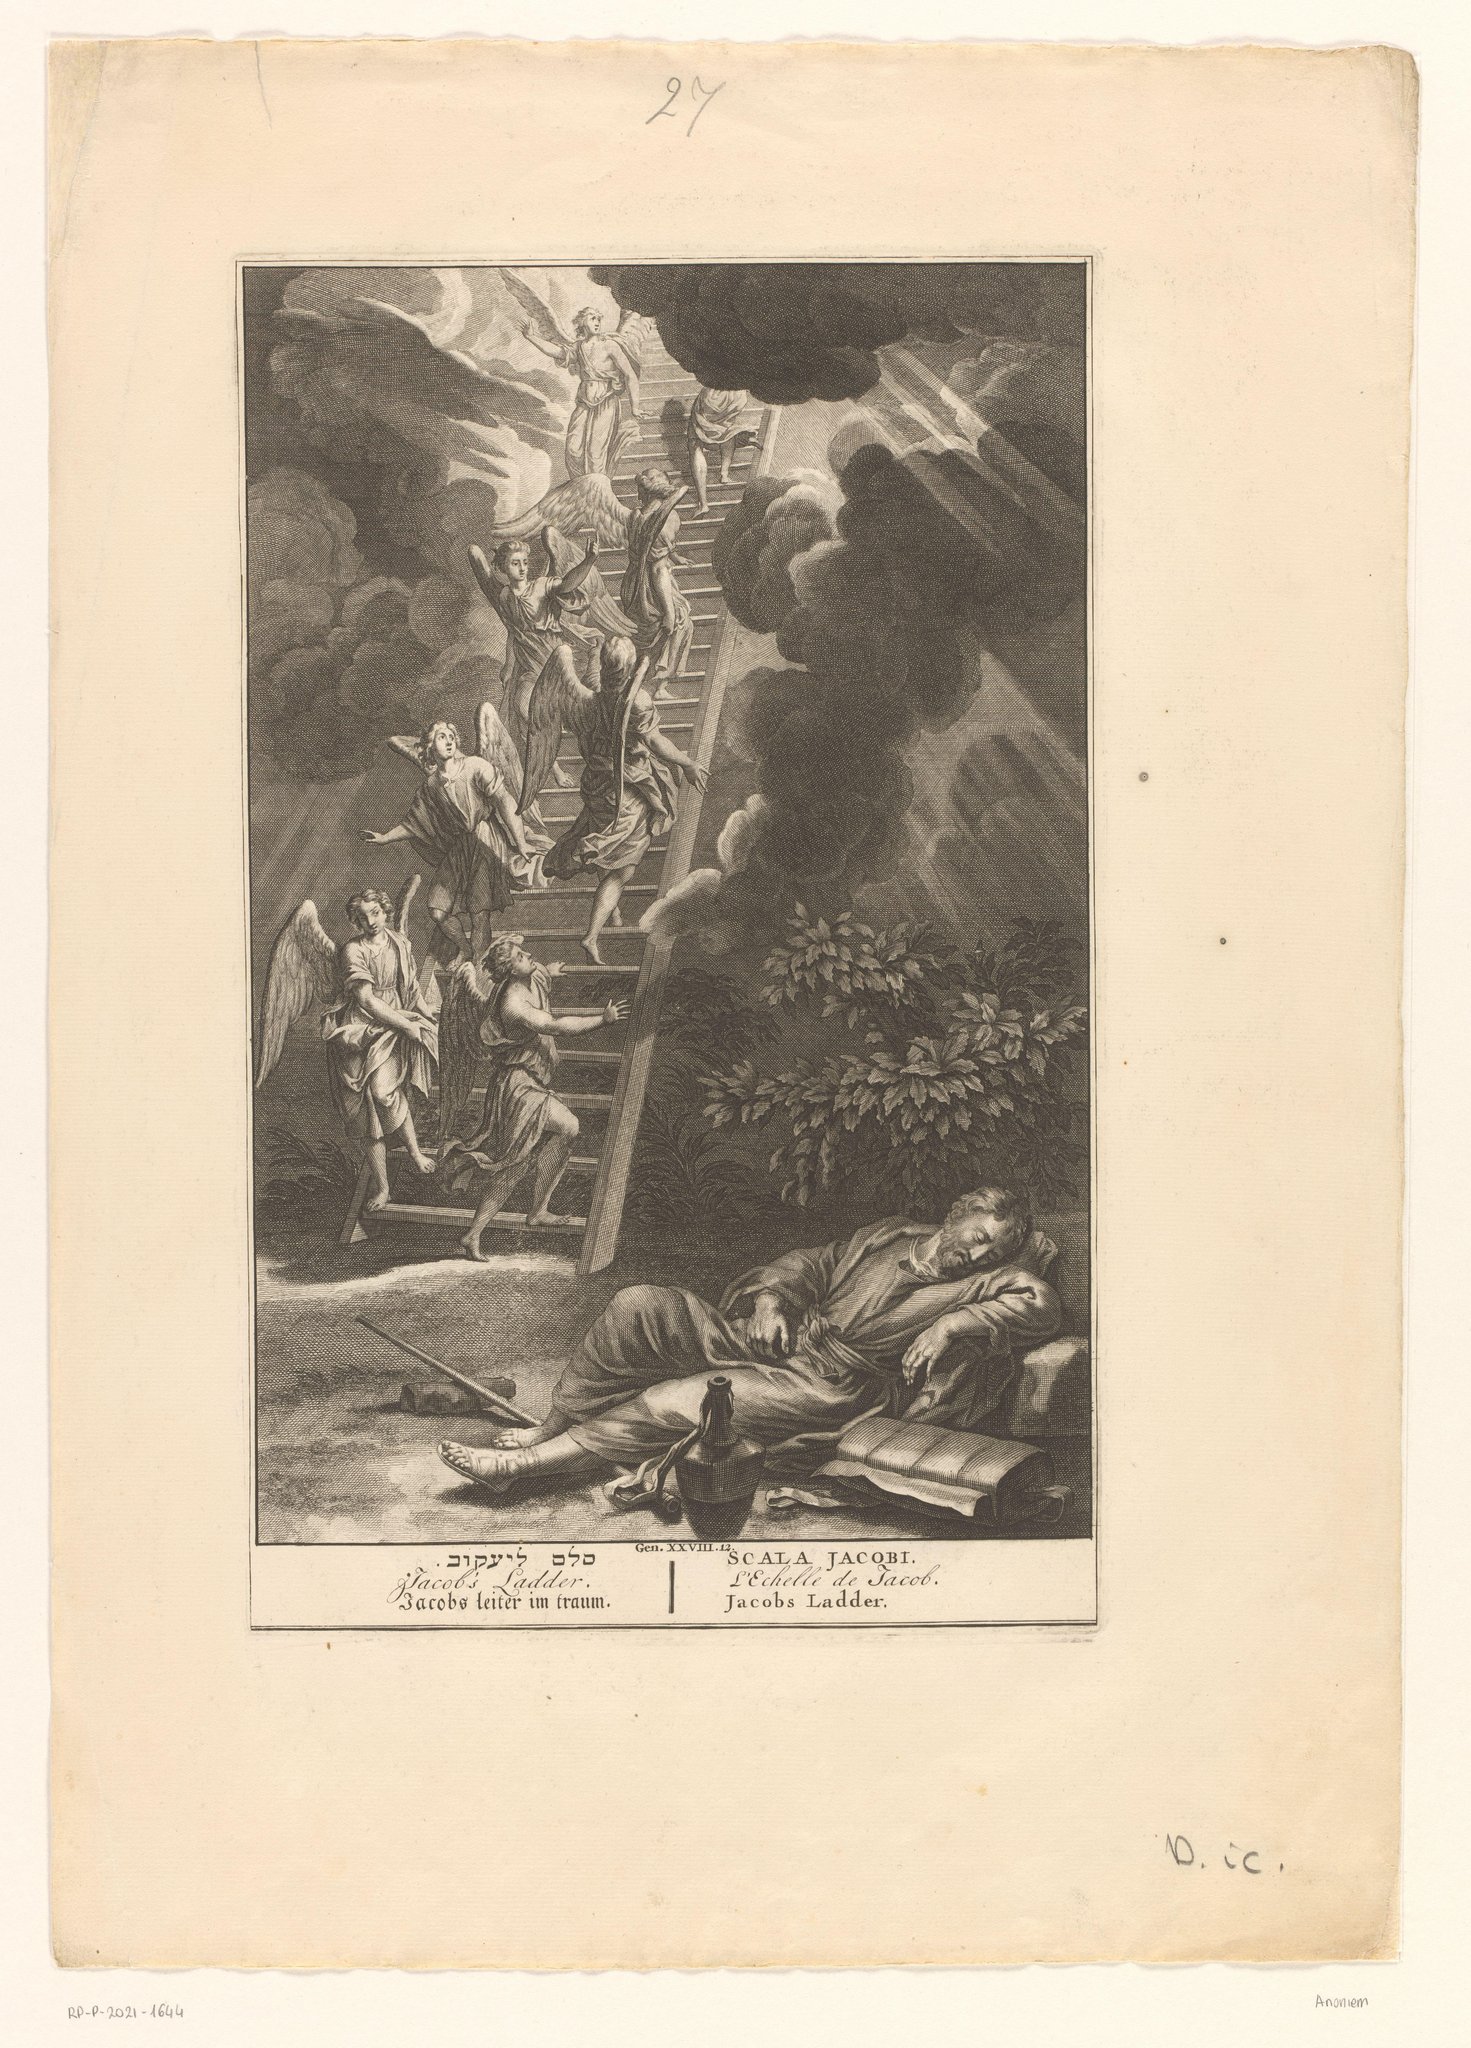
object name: print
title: Bijbelvoorstellingen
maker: Anonymous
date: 1711-1728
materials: paper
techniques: engraving, etching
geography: amsterdam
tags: the dream of jacob: while sleeping on the ground with a stone for pillow jacob sees a ladder reaching from earth to heaven with angels going up and down; usually with god at the top of the ladder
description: De prent is gebruikt voor 'Figures de la Bible', uitgegeven in Amsterdam door Bernard Picart in 1720. De prent is waarschijnlijk ook gebruikt voor: Taferelen der voornaamste geschiedenissen van het Oude en Nieuwe Testament (...) door de vermaarde kunstenaars Hoet, Houbraken, en Picart getekent (...) en met beschrijvingen uitgebreid. Den Haag: Pieter de Hondt, 1728. Een aantal prenten in deze publicaties is 1711 gedateerd. Mogelijk zijn de prenten dus al gebruikt voor een eerdere publicatie.